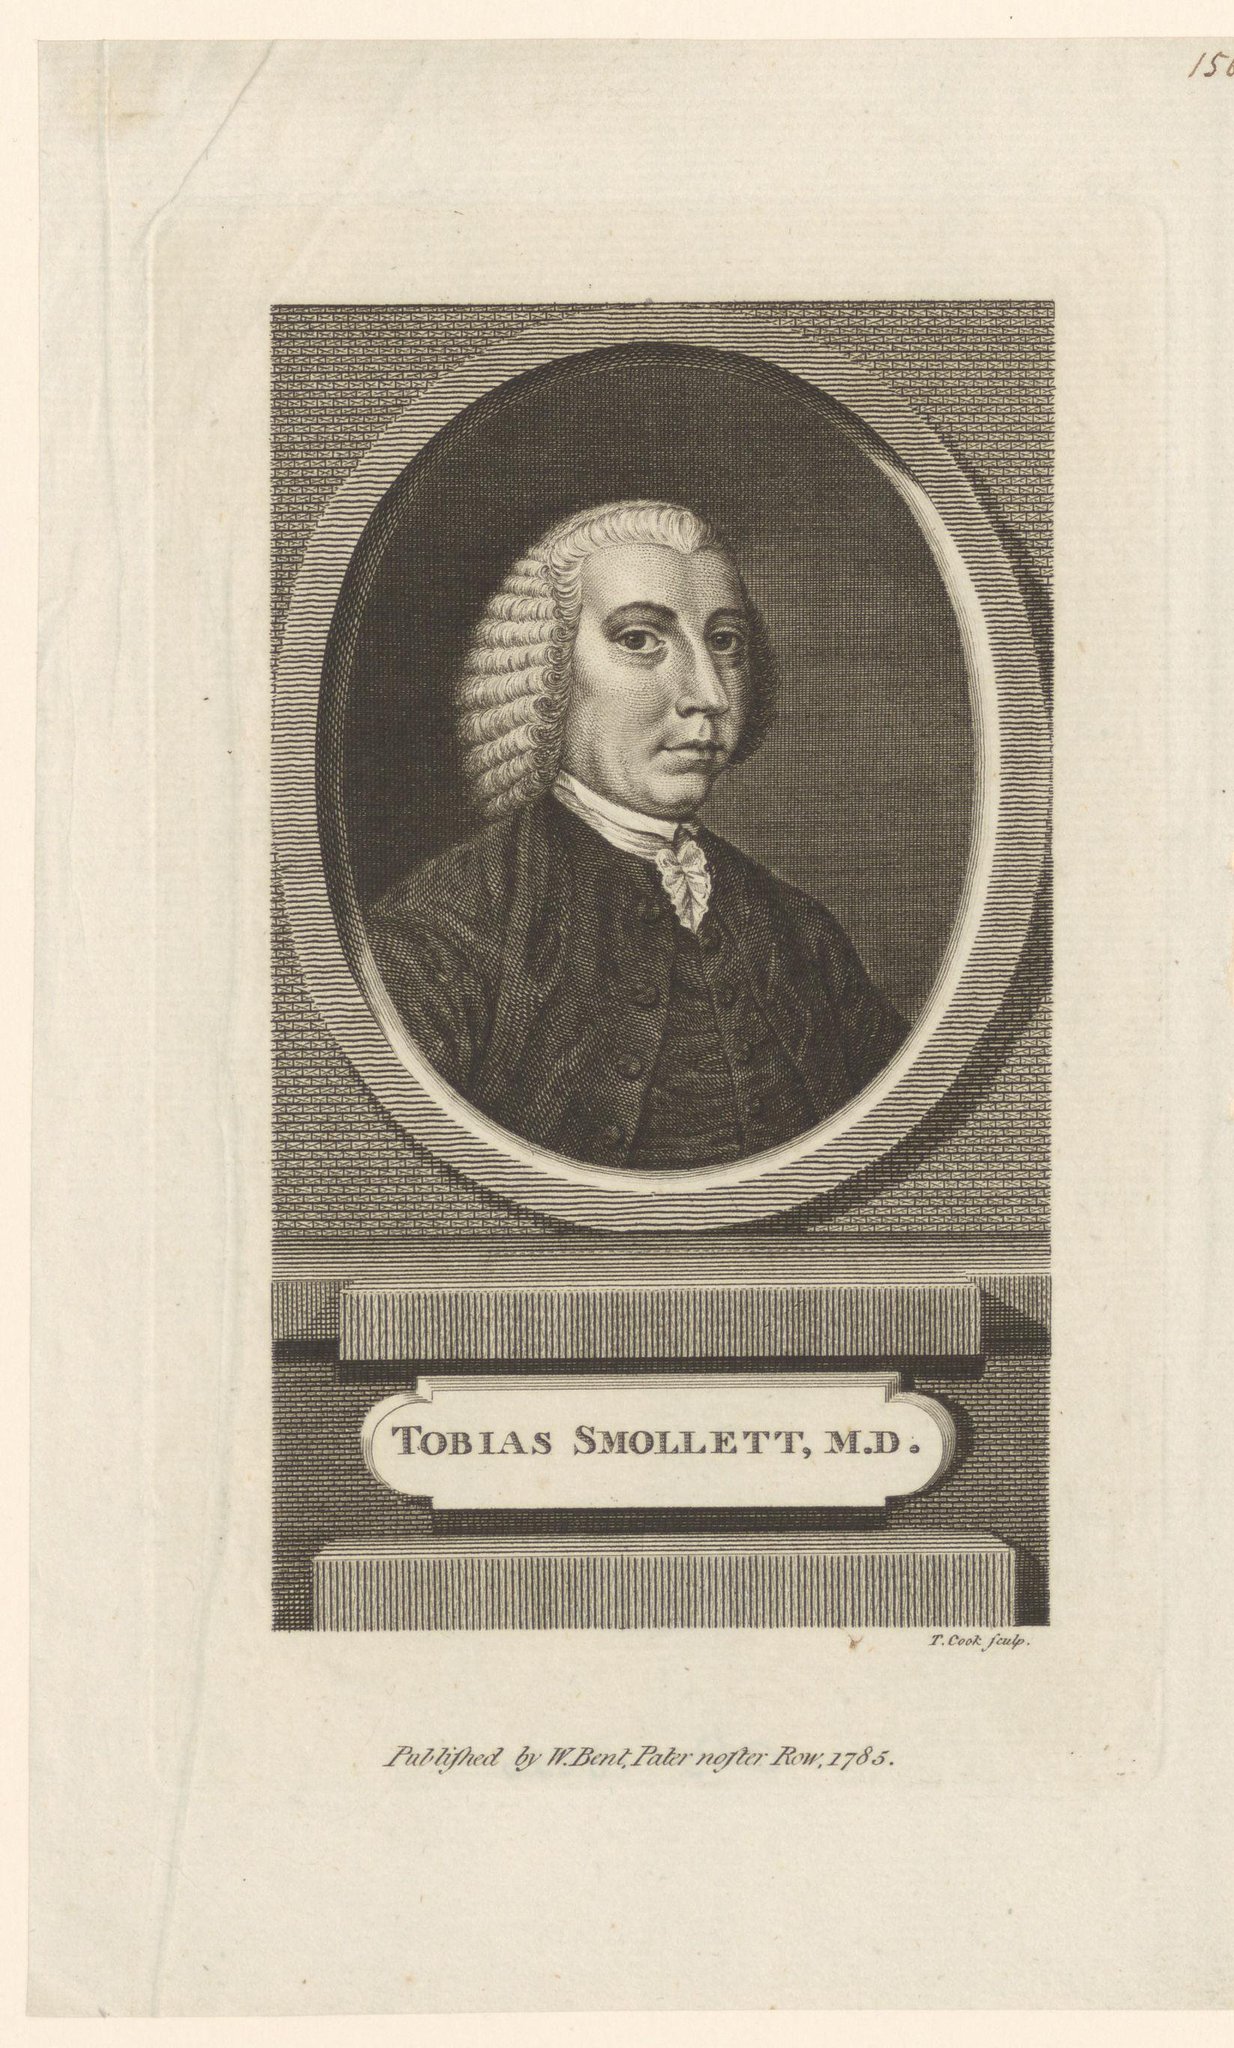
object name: print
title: Portret van Tobias Smollett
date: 1785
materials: paper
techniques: engraving, etching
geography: london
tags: historical persons, writer, poet, author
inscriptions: collector's mark: Lugt 2228, number: ‘156’